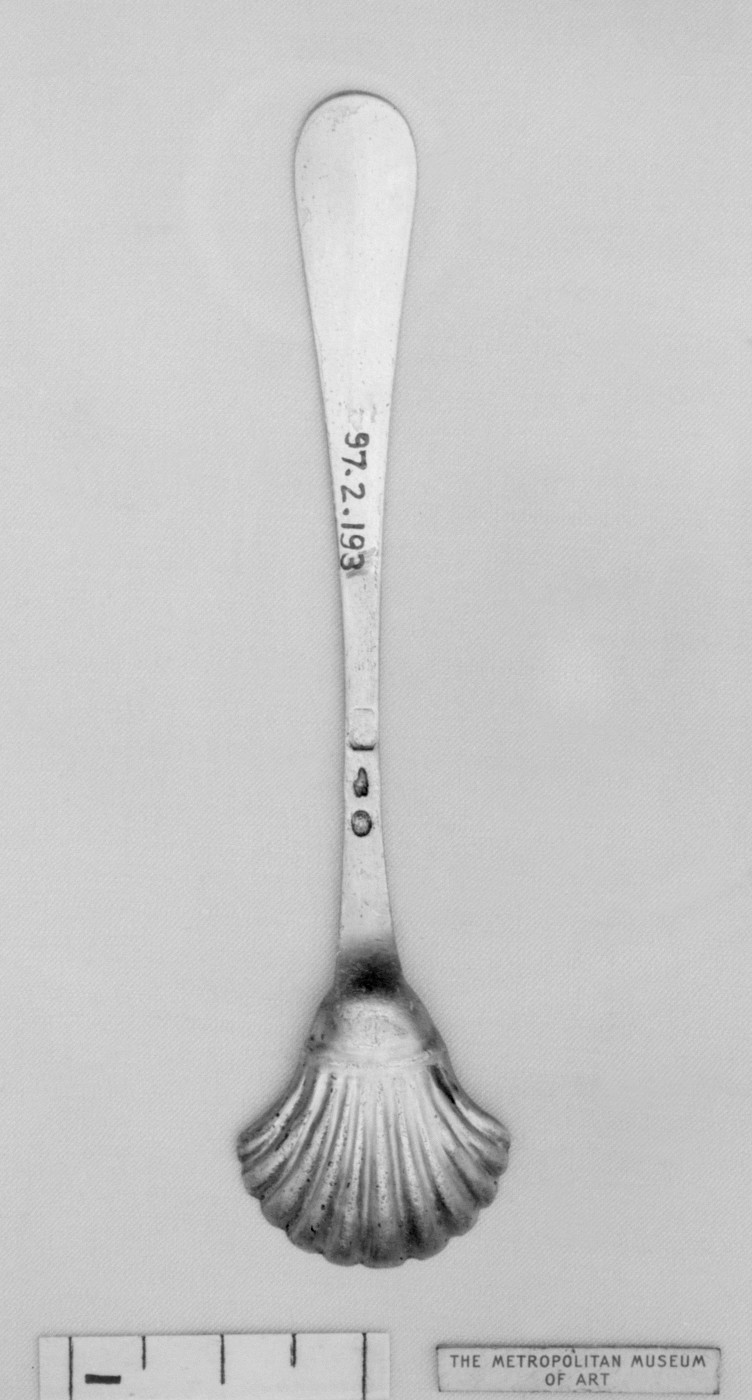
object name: salt spoon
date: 1819-1838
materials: gilt, silver